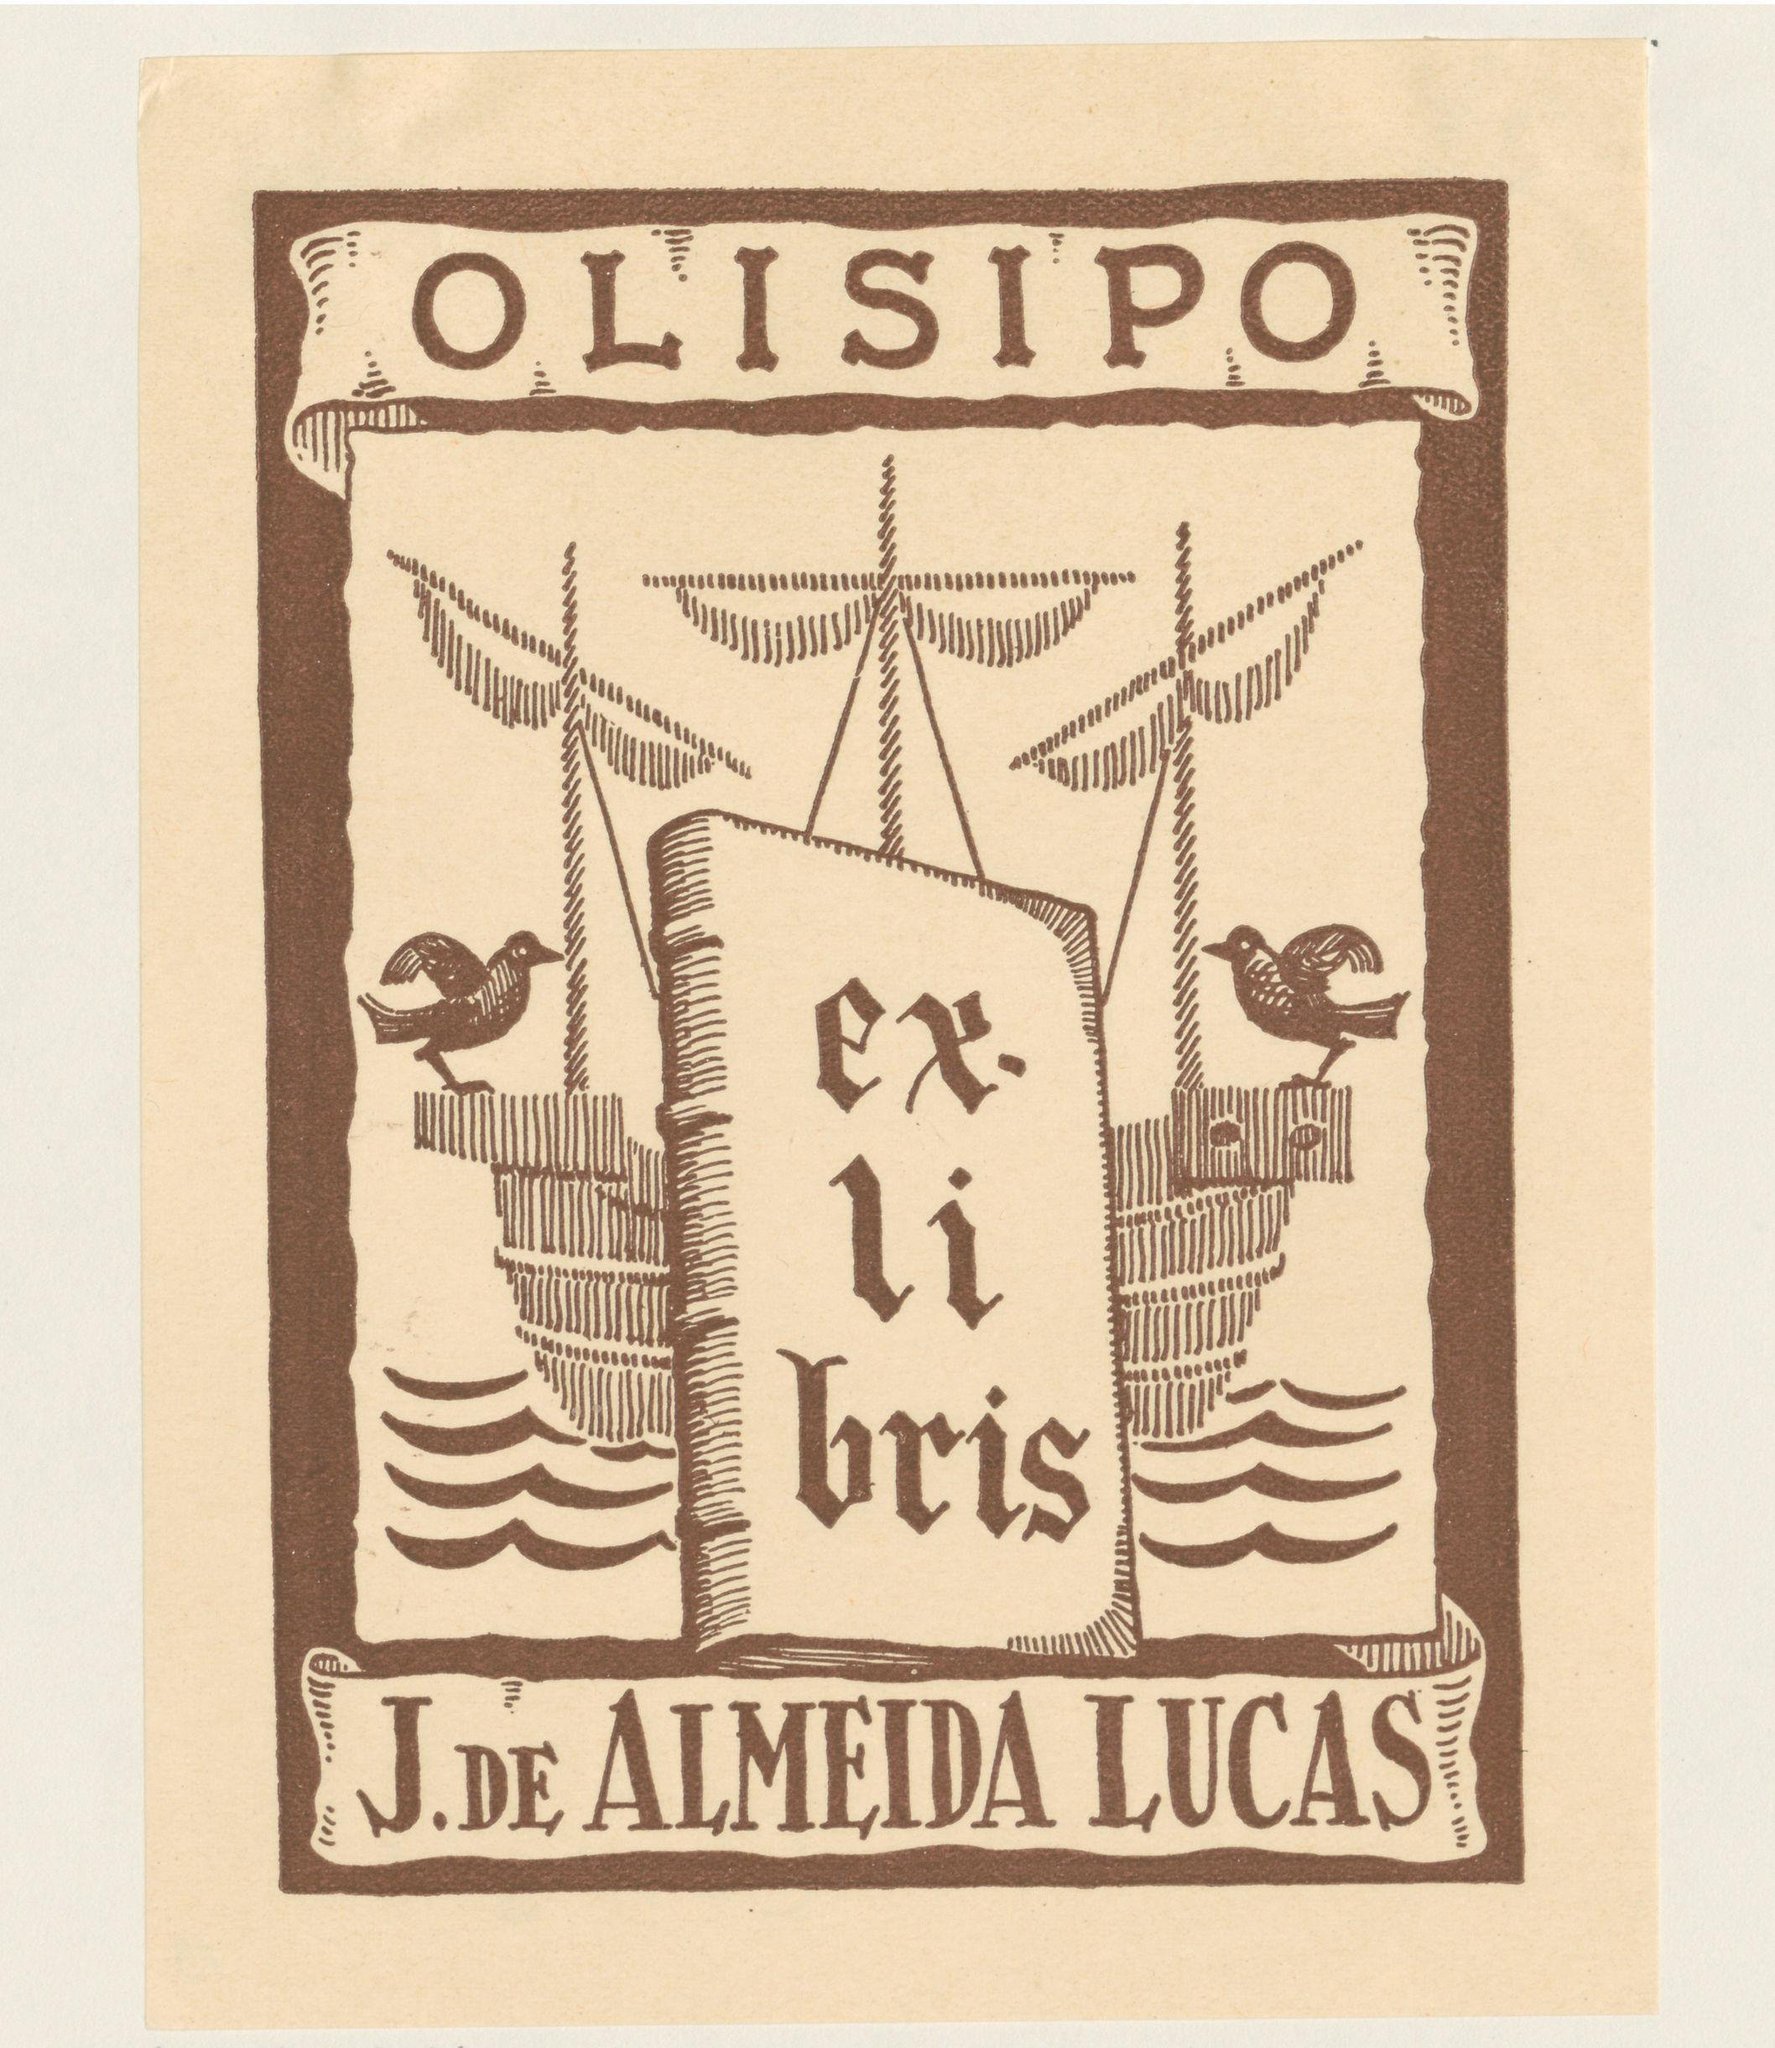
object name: bookplate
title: Ex libris van J. de Almeida Lucas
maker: Anonymous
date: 1900-1950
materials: paper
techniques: printing block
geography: portugal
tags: sailing-ship, sailing-boat, birds, book